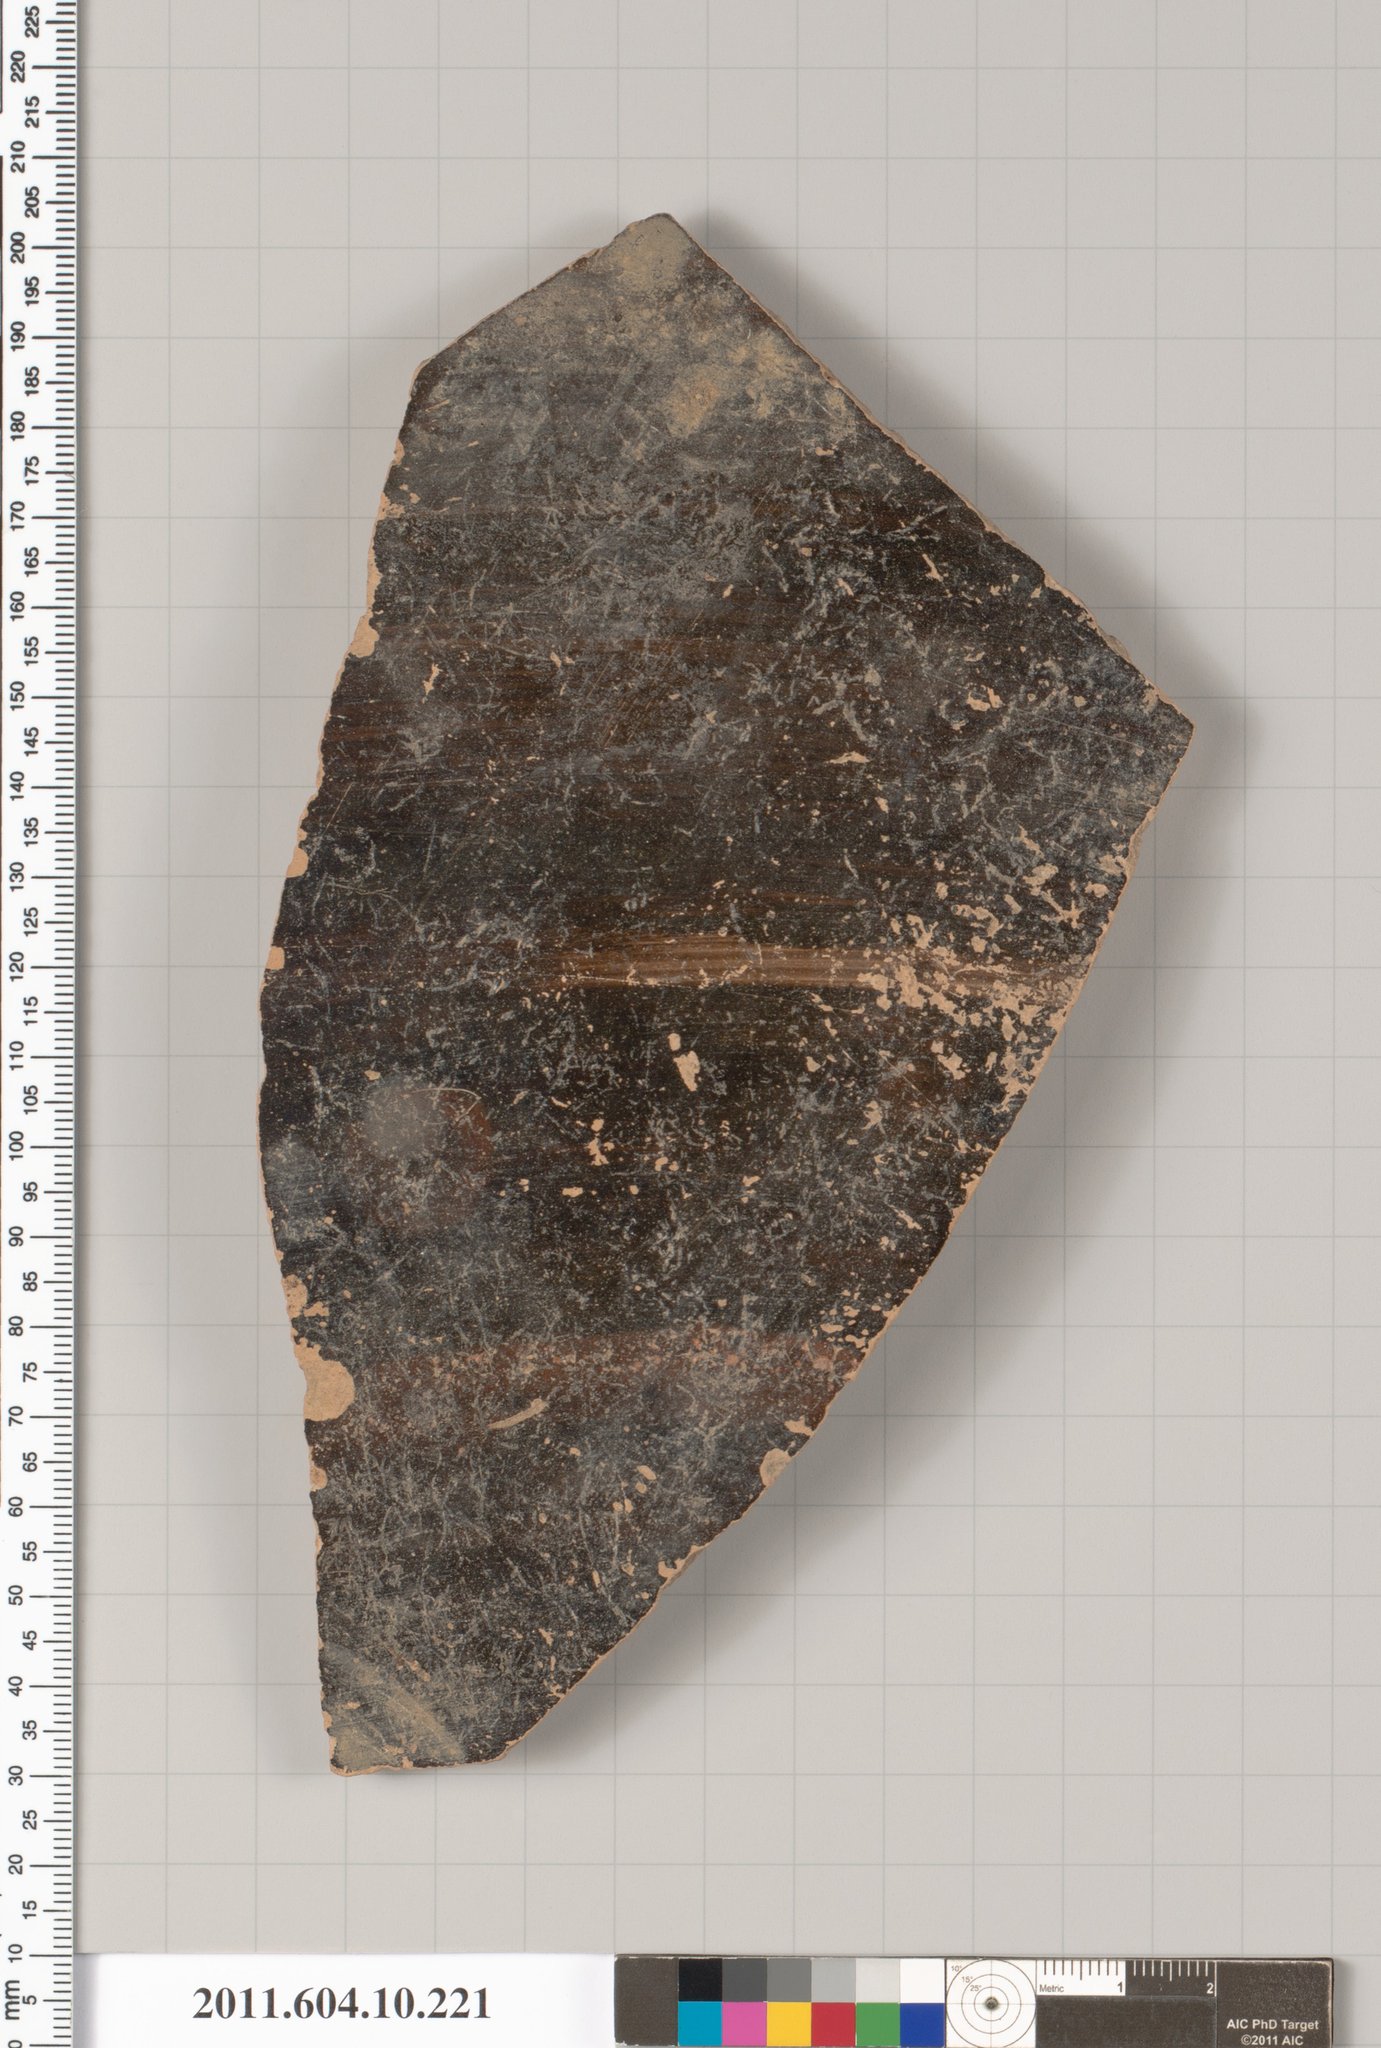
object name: undetermined closed shape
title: Terracotta fragment of a closed shape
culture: etruscan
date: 601-700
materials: terracotta